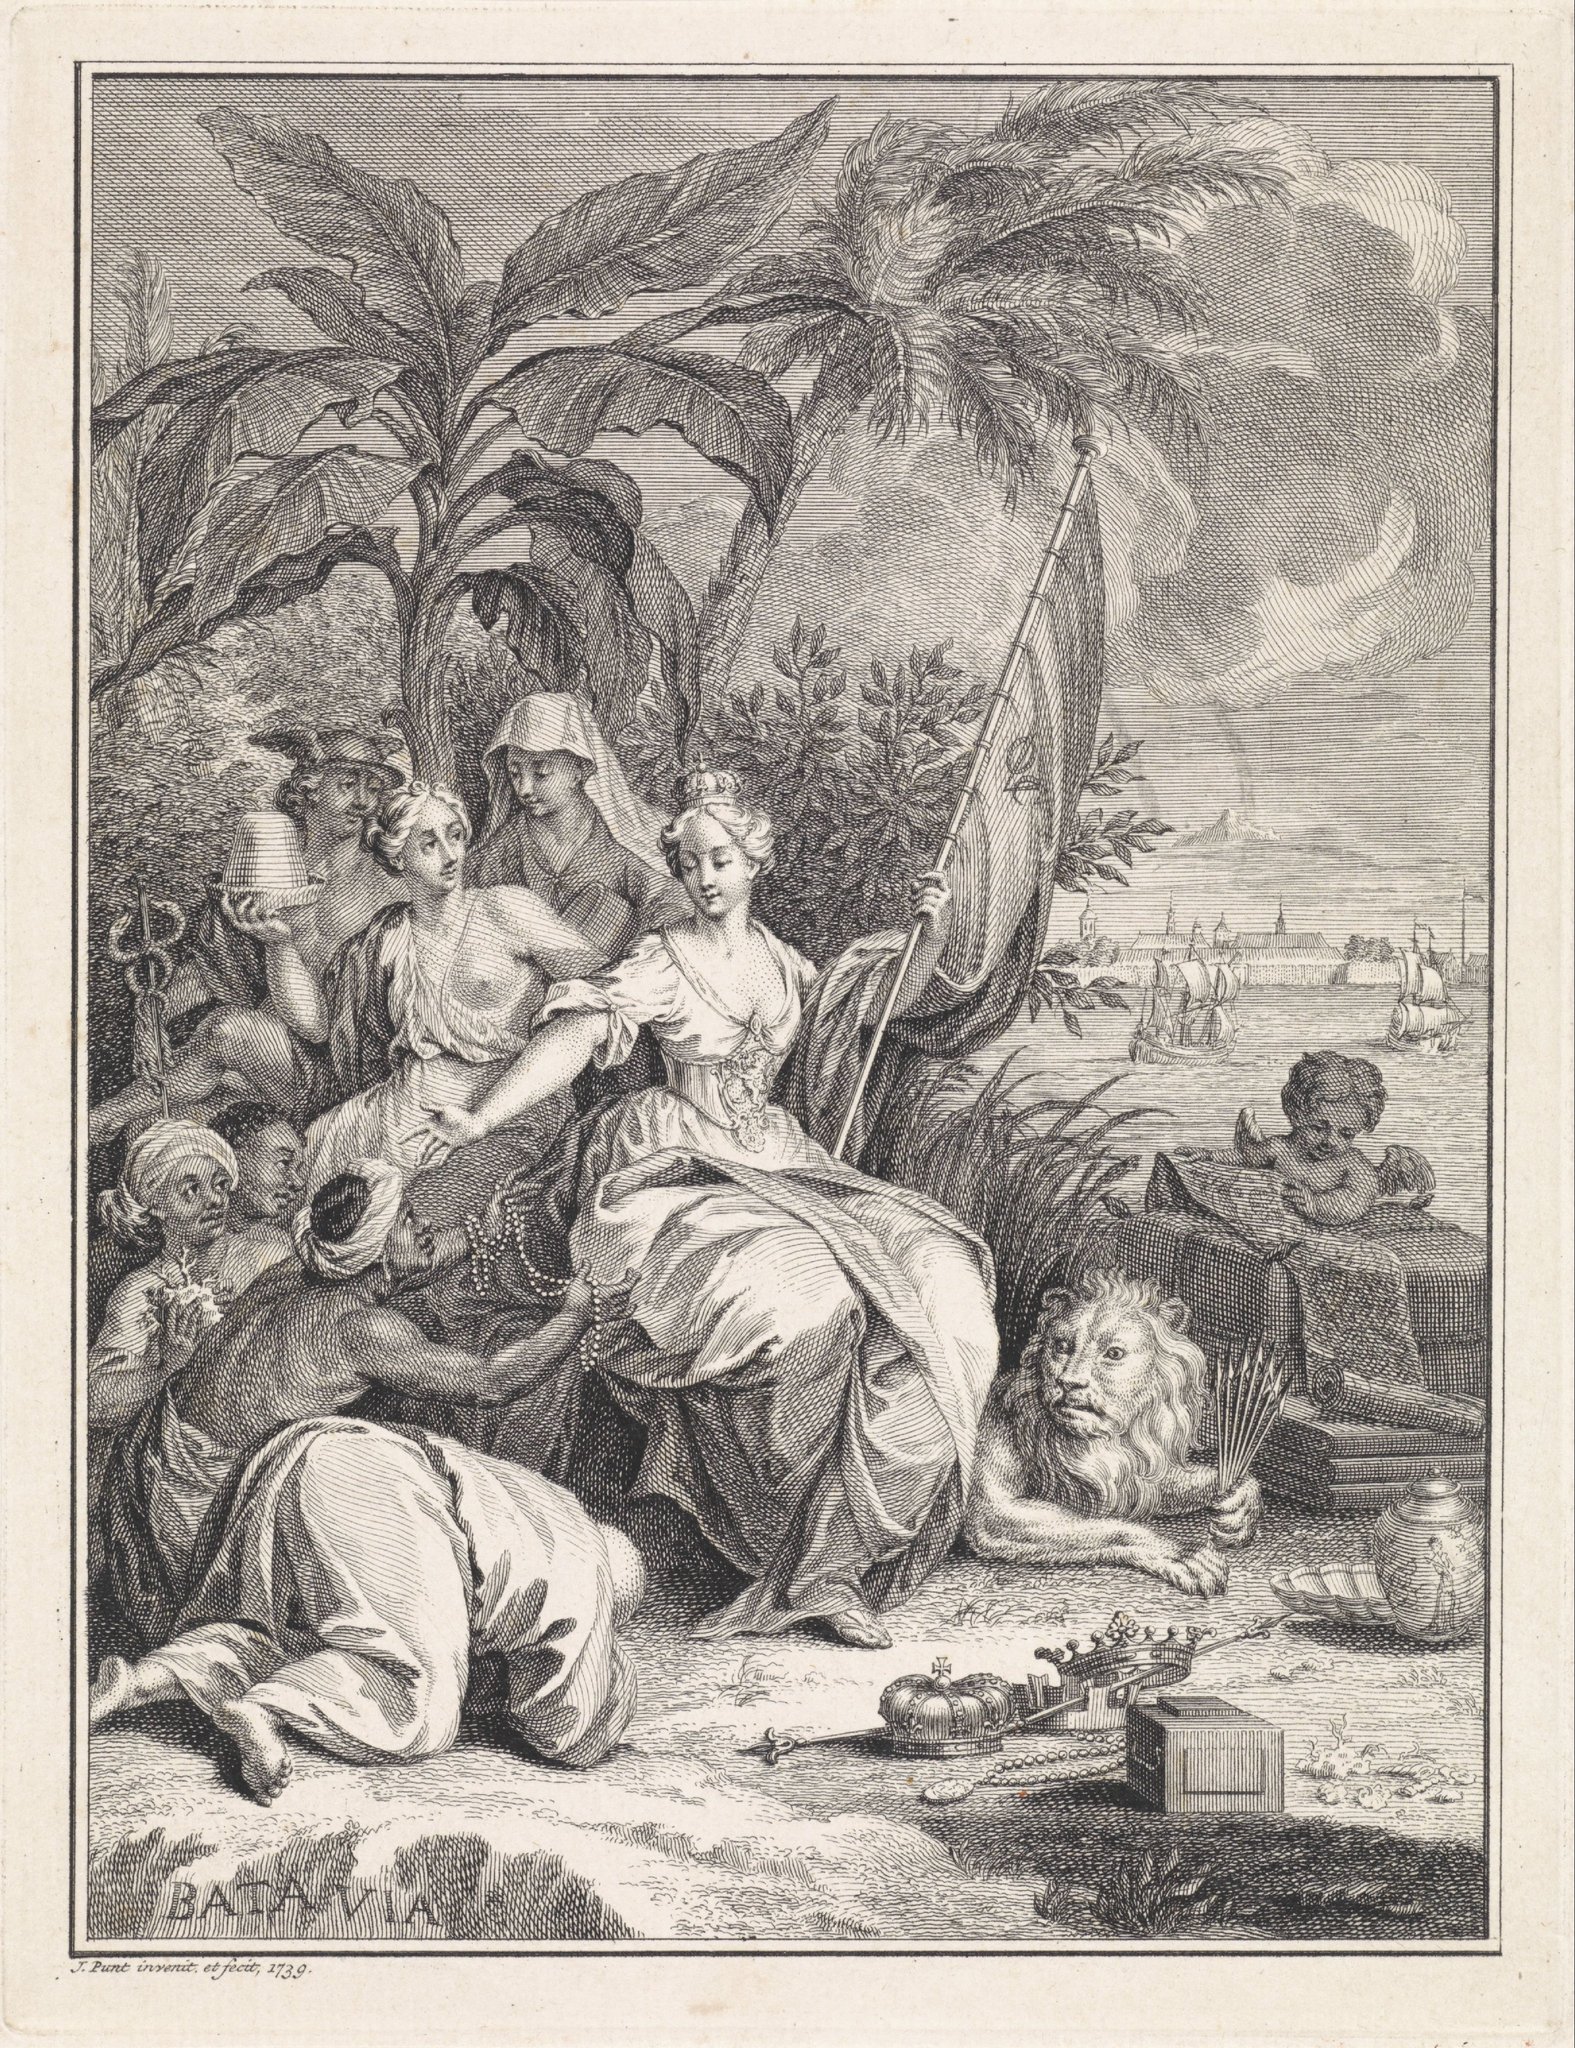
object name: titelblad, titelpagina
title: Allegorie op de VOC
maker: jan punt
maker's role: draughtsman, print maker, publisher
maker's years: 1711-1779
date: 1739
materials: paper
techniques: engraving, etching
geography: amsterdam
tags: asiatic races and peoples, personifications of countries, nations, states, districts, etc., (story of) mercury (hermes), africans, freedom, liberty; 'libertà' (ripa), batavia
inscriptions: collector's mark: Lugt 240, title: ‘Batavia’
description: Allegorie op de Verenigde Oost-Indische Compagnie. Batavia houdt een vlag vast met het monogram van de VOC. Naast haar ligt de Hollandse leeuw. Afrikaanse en Oosterse mannen buigen voor haar en bieden haar cadeaus met koninklijke voorrechten aan. Links staat Mercurius, god van de handel, Vrijheid en een derde allegorische figuur. Aan de rechterzijde bekijkt een engeltje een kostbare stof. Op de achtergrond een gezicht op de stad Batavia, het middelpunt van de bezittingen van de Nederlanders. De prent illustreert de trots van de Nederlanders op hun koloniale gebieden.